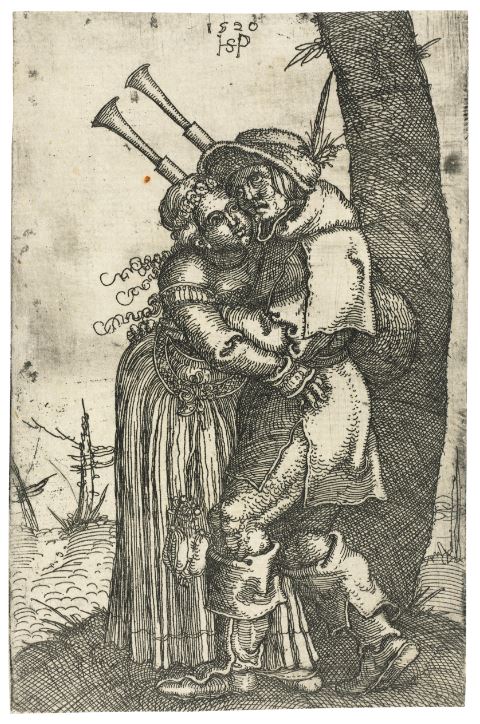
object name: print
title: The Bagpiper and his Mistress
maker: sebald beham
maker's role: artist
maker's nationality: german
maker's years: 1500-1550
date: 1520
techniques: etching